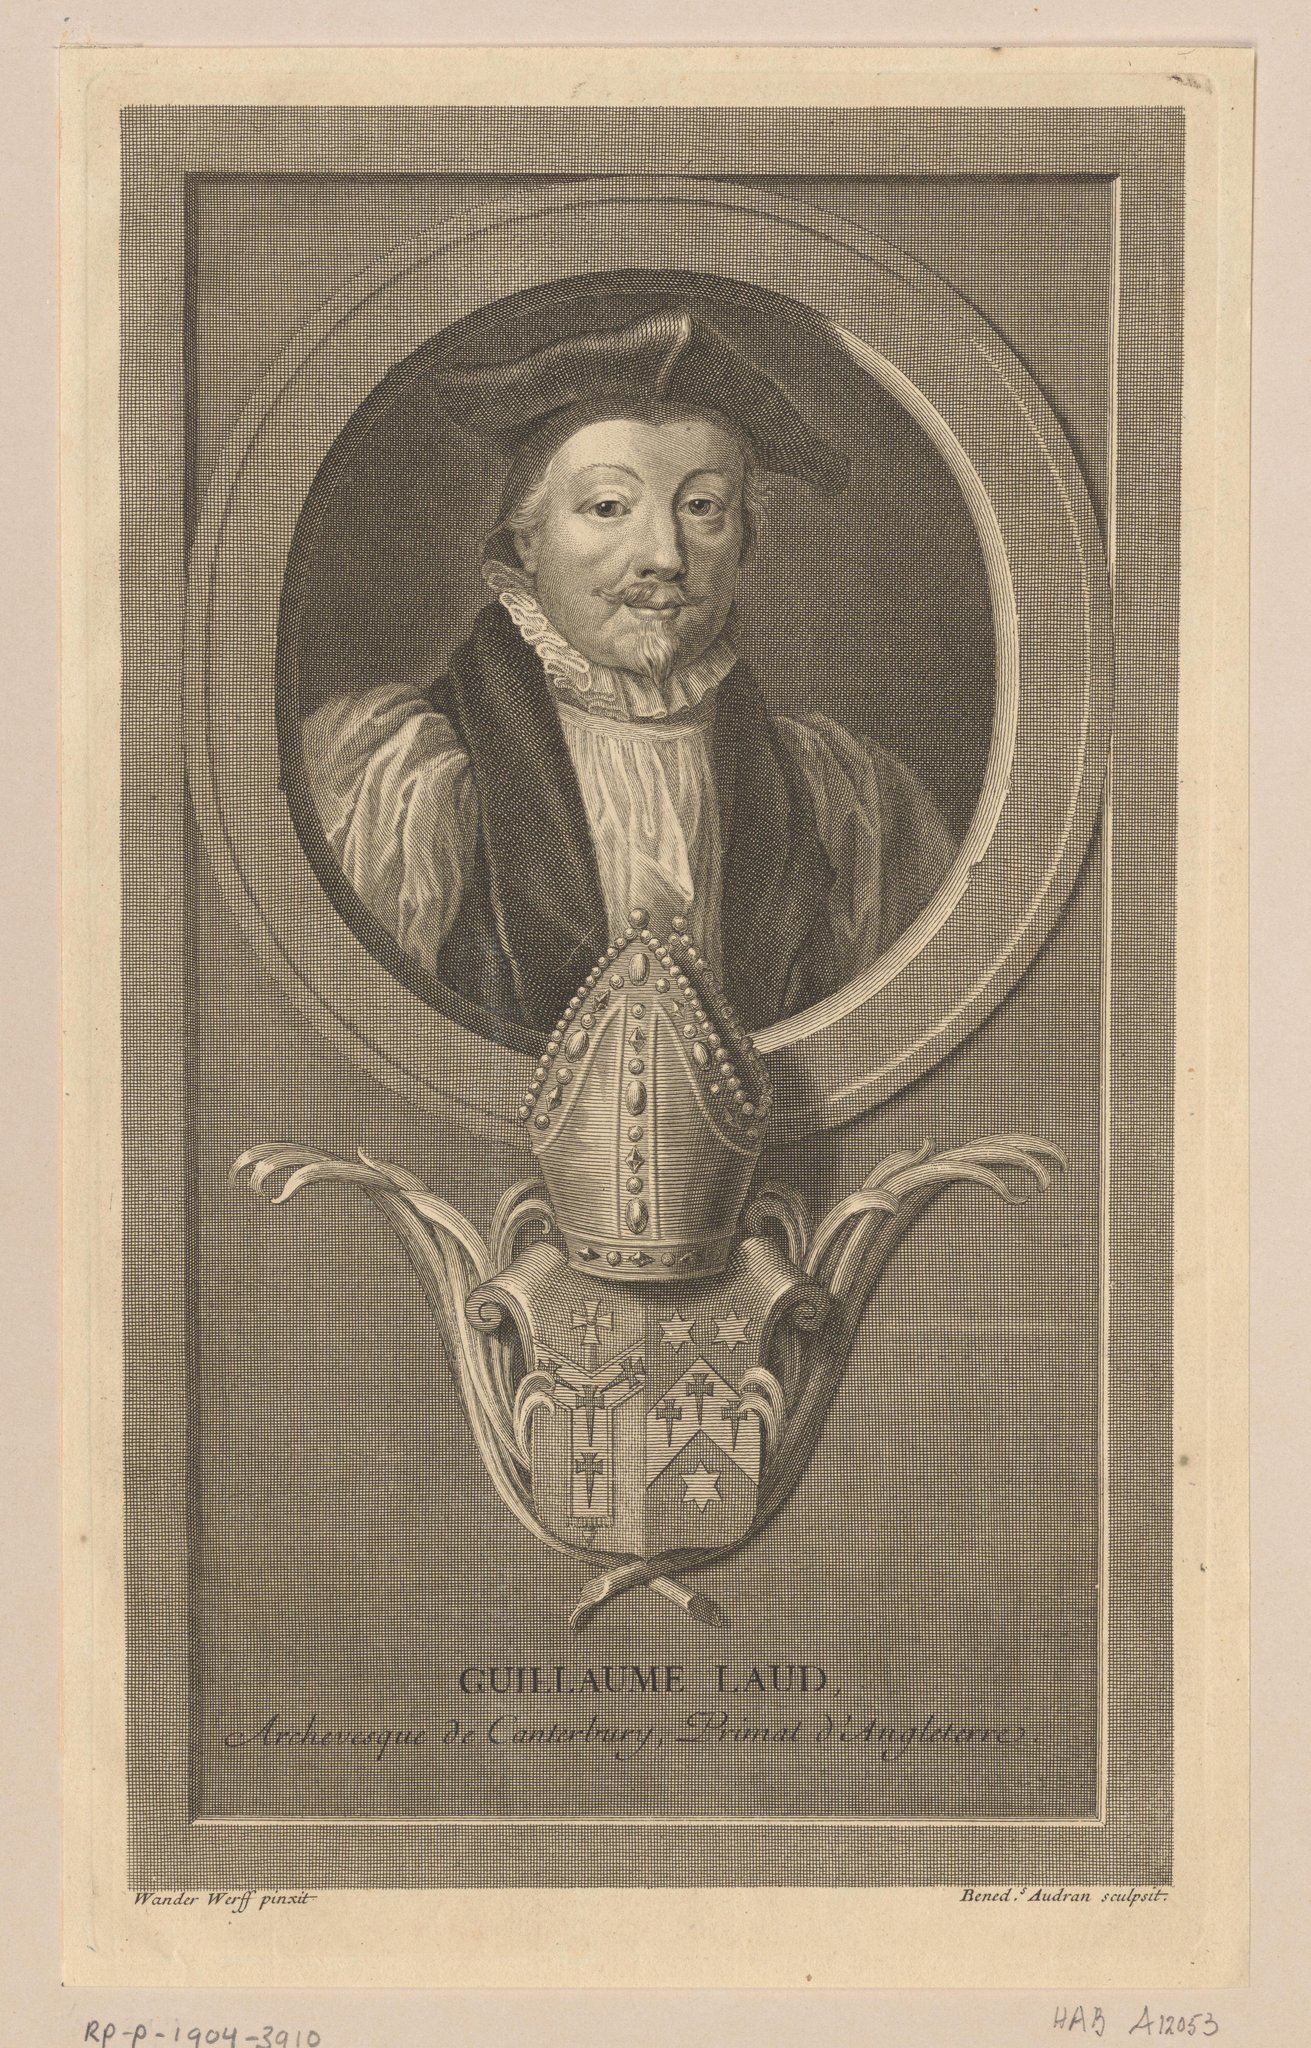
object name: book illustration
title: Portret van William Laud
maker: benoît audran (i)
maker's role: print maker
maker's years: 1661-1721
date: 1713-1723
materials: paper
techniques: engraving, etching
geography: france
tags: clergyman, insignia of bishop, e.g. mitre, crozier, historical persons, armorial bearing, heraldry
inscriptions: collector's mark: Lugt 2228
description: Prent waarschijnlijk uit: Larrey, Isaac de. Histoire d'Angleterre, d'Écosse et d'Irlande (...). Rotterdam: Fritsch & Böhm, 1713, dl. 4. Of uit de editie van 1723.